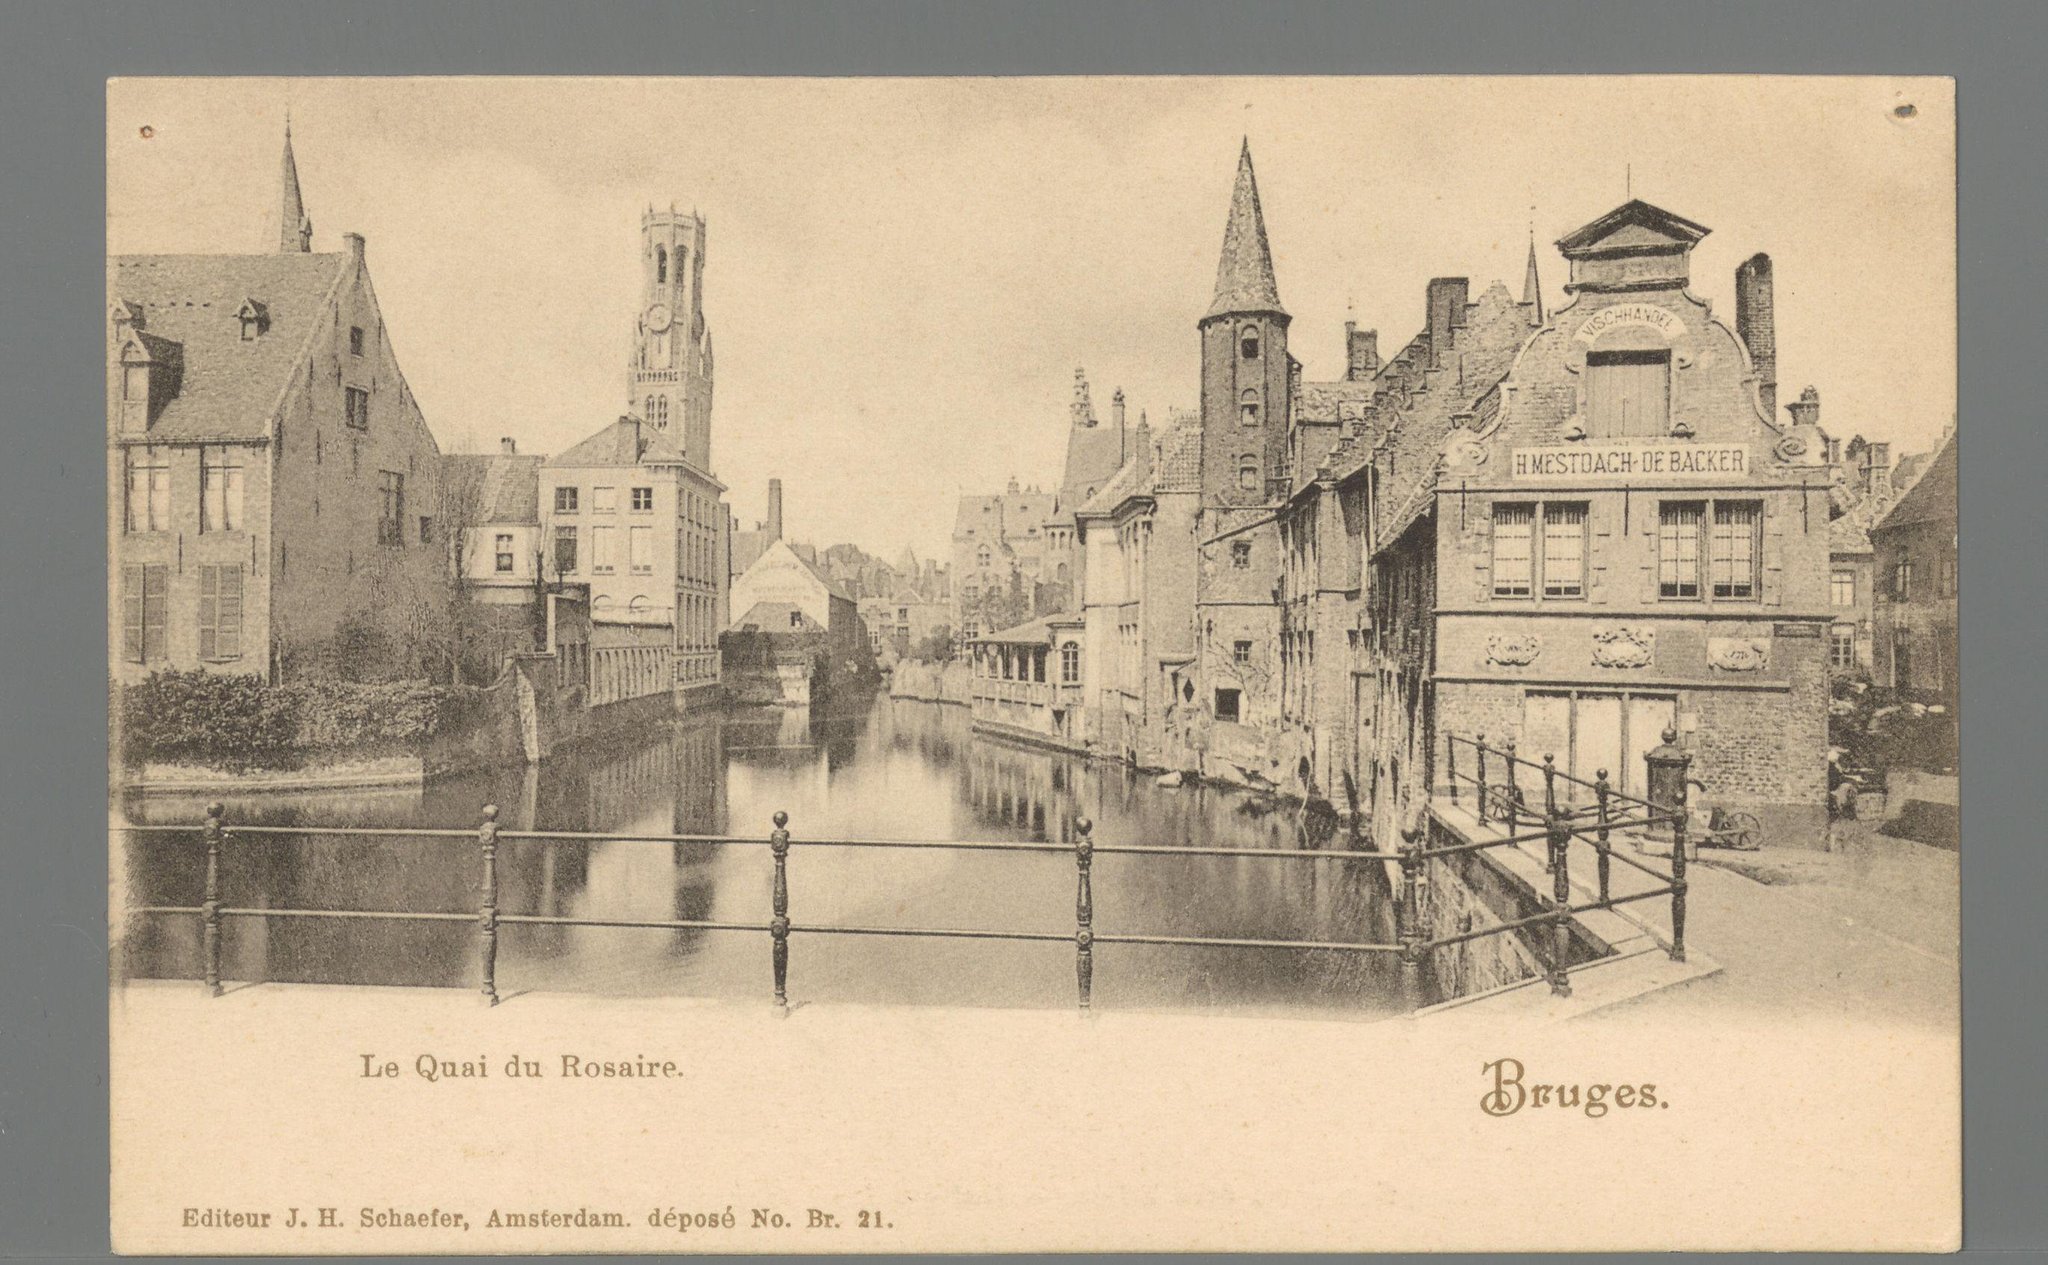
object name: ansichtkaart, prentbriefkaart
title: Le Quai du Rosaire. Bruges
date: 1892-1905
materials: cardboard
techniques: photograph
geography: bruges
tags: city-view, and landscape with man-made constructions, canal, bruges